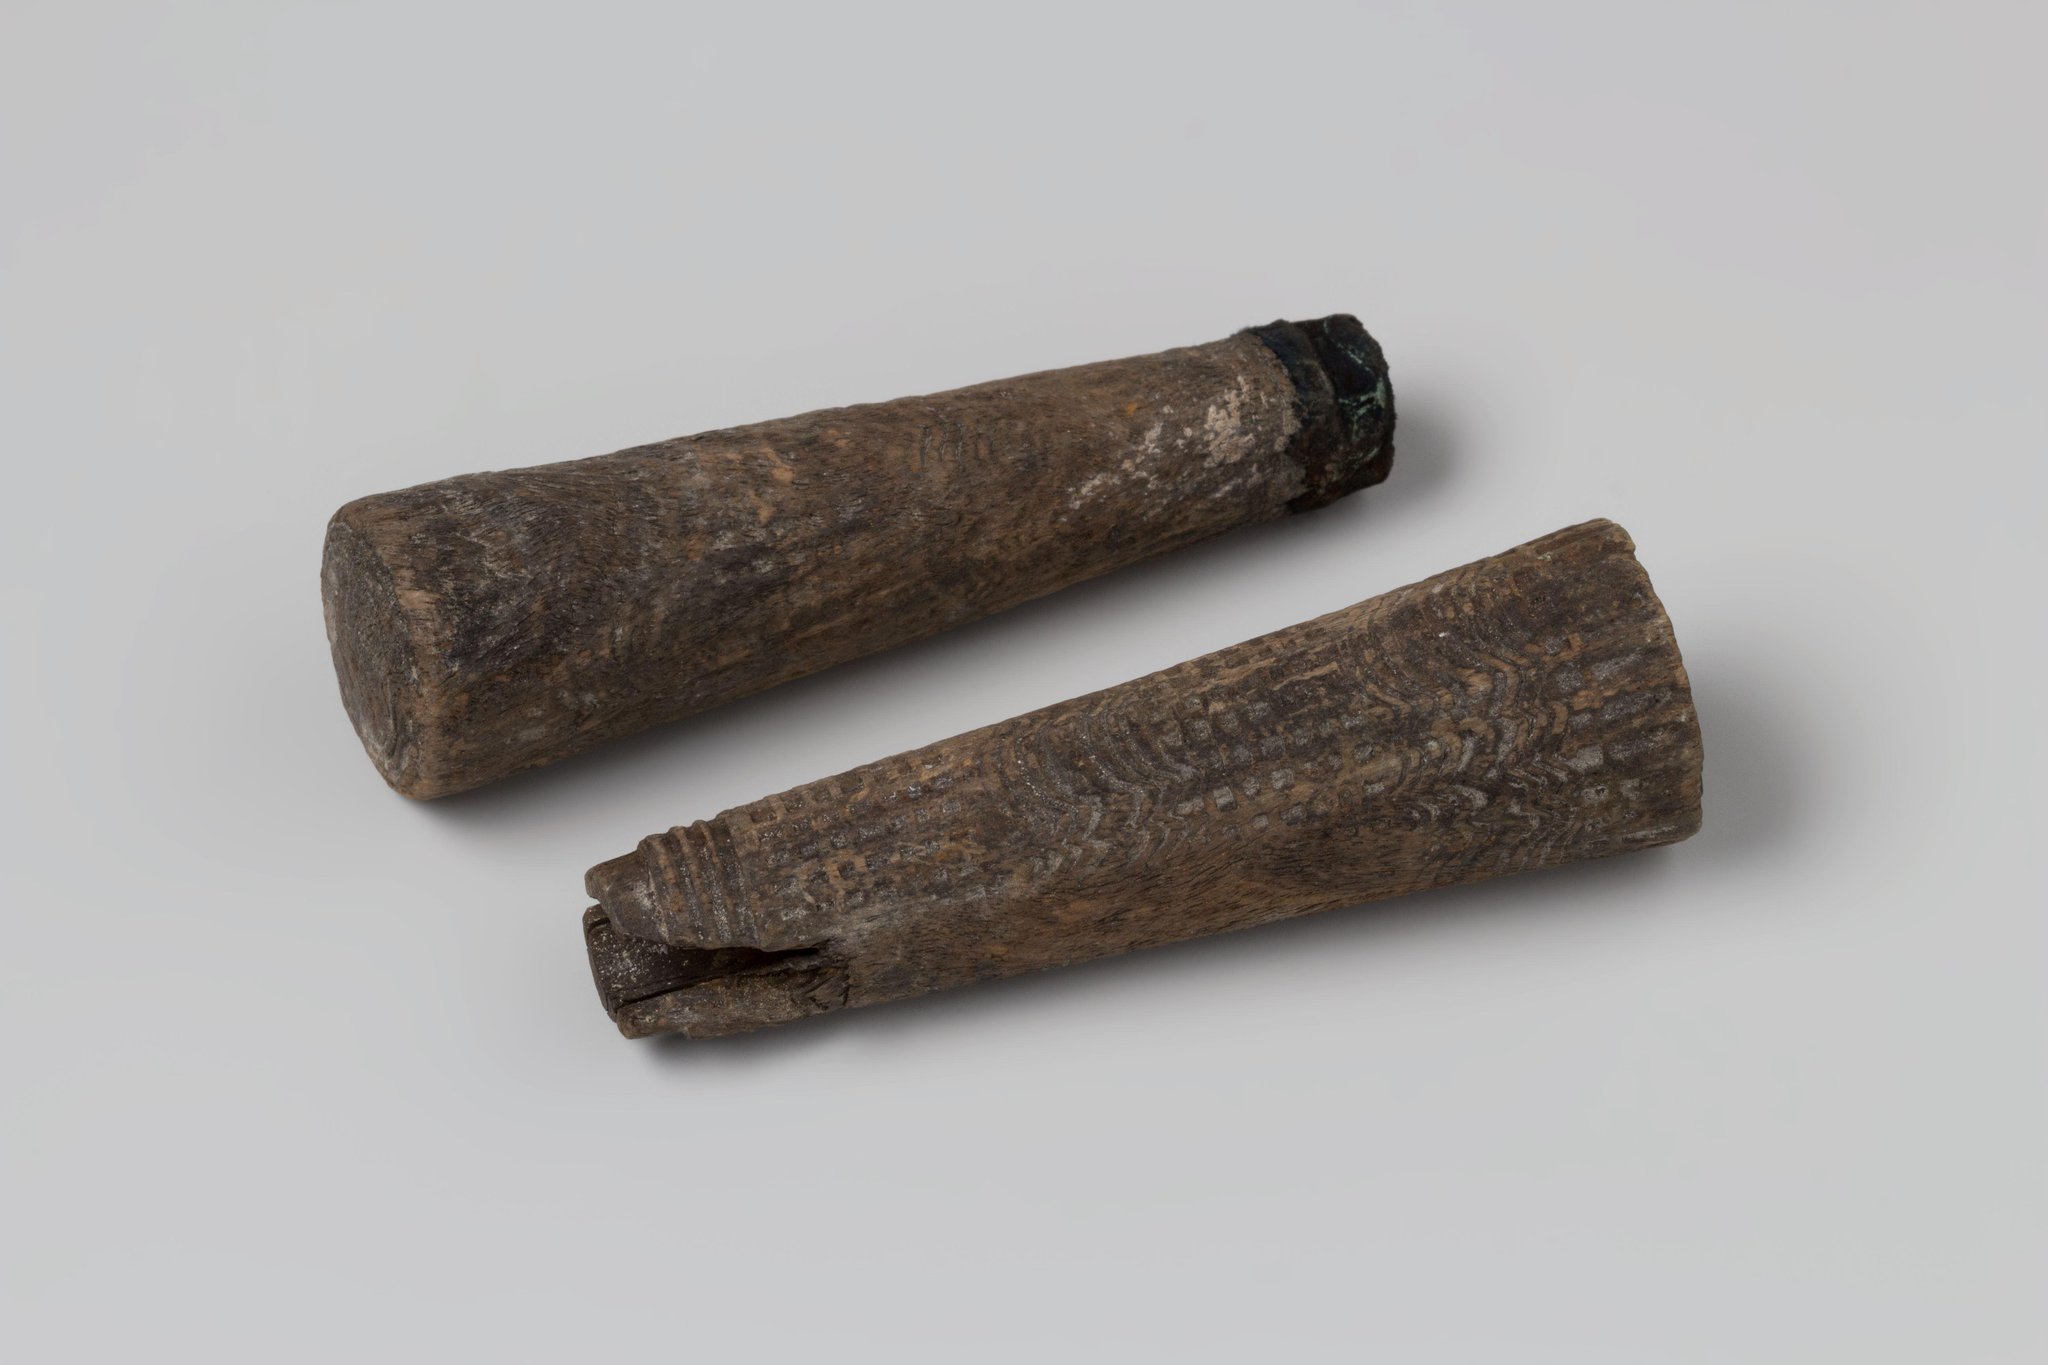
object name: knife handle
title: Messenheften uit het wrak van de Oost-Indiëvaarder Hollandia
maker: Anonymous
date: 1700-1743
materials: copper, wood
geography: netherlands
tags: verenigde oostindische compagnie, hollandia (schip), annet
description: Knife, handle, cylindrical: tapering; id. NG 1979-403H, ferrules, id. NG 1980-27H426.